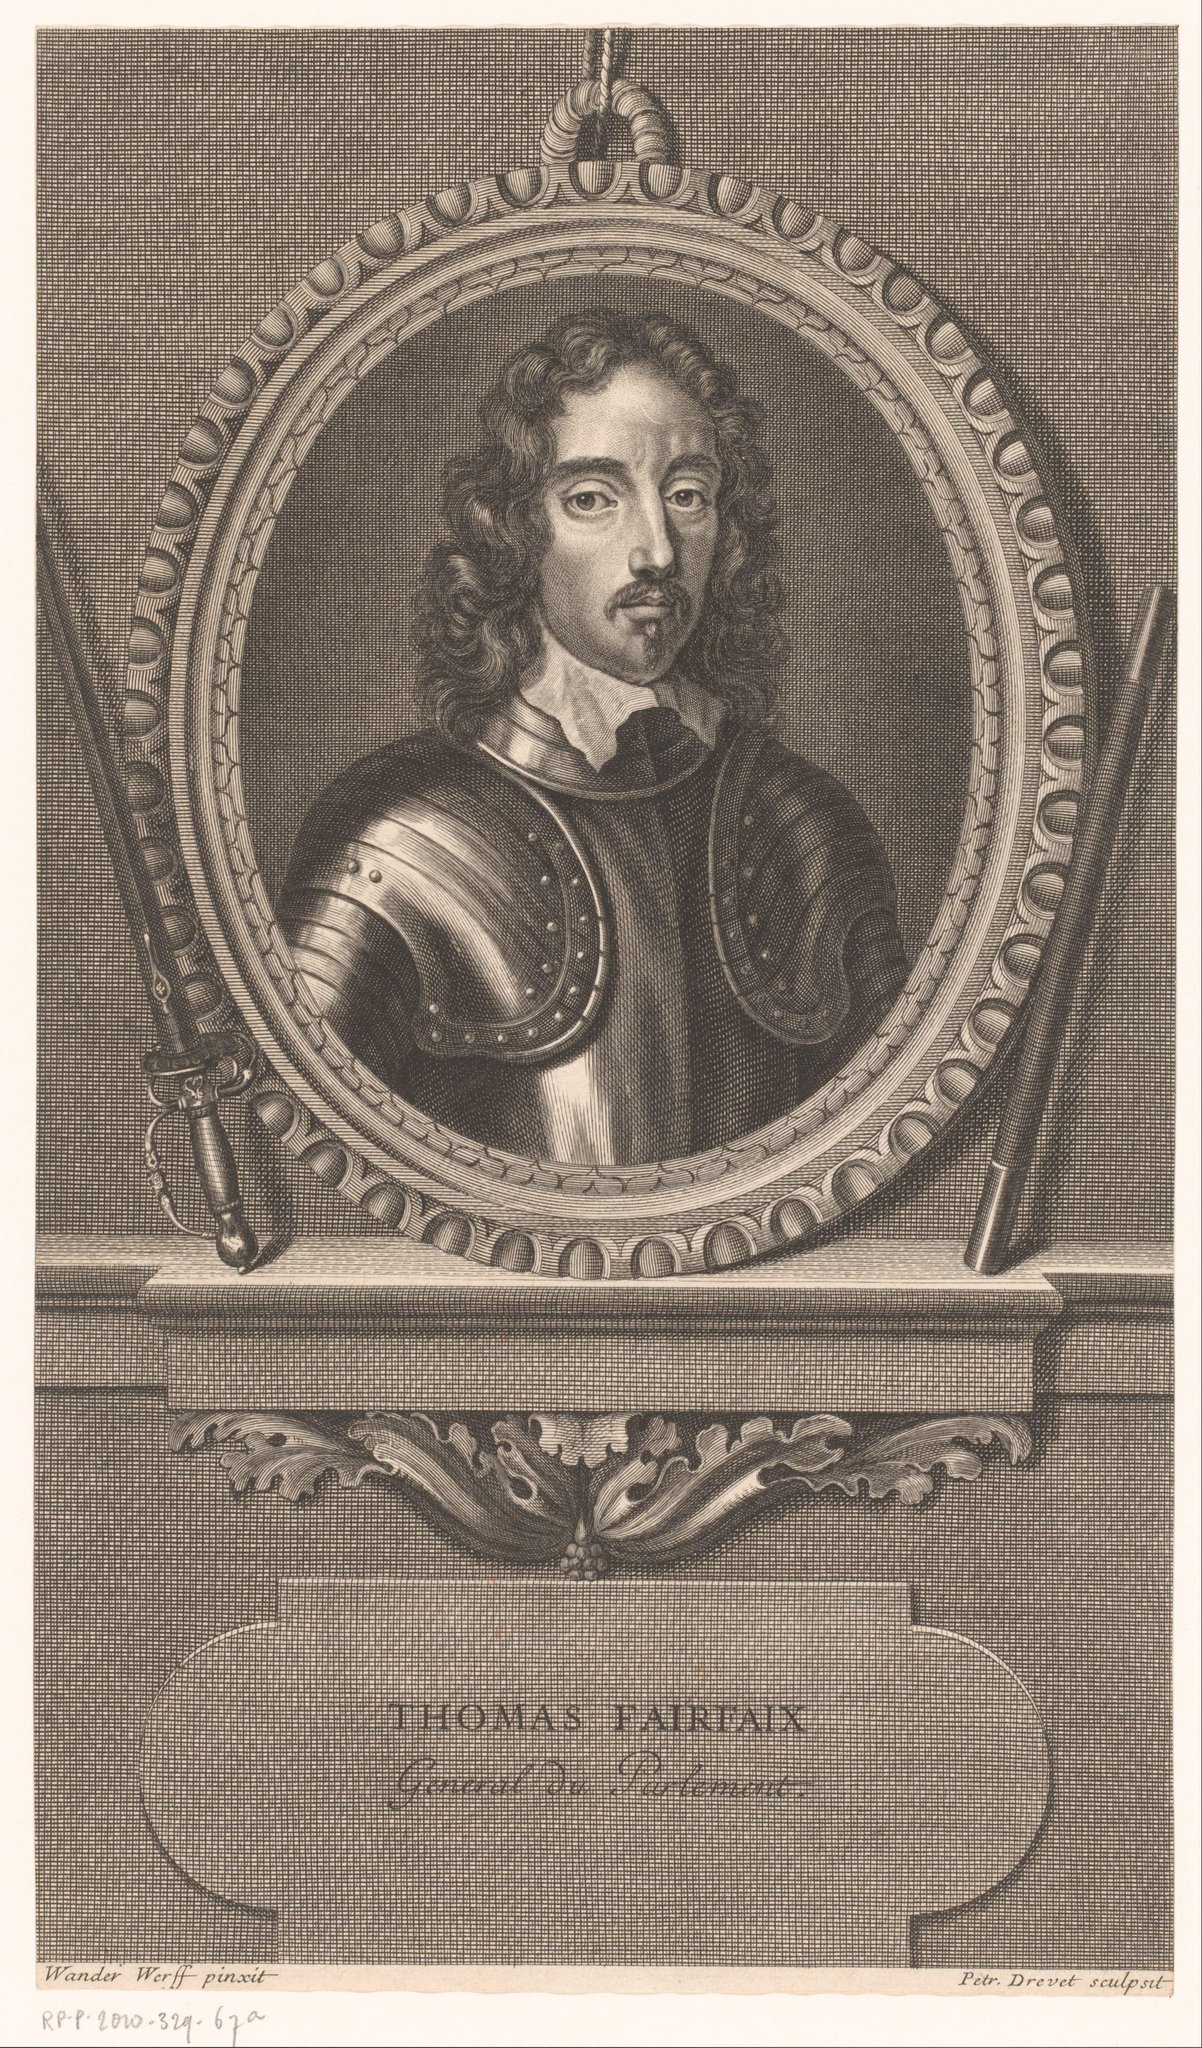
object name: print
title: Thomas Fairfax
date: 1673-1738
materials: paper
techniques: engraving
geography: france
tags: ornament ~ medallion, historical persons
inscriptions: collector's mark: Lugt 2228